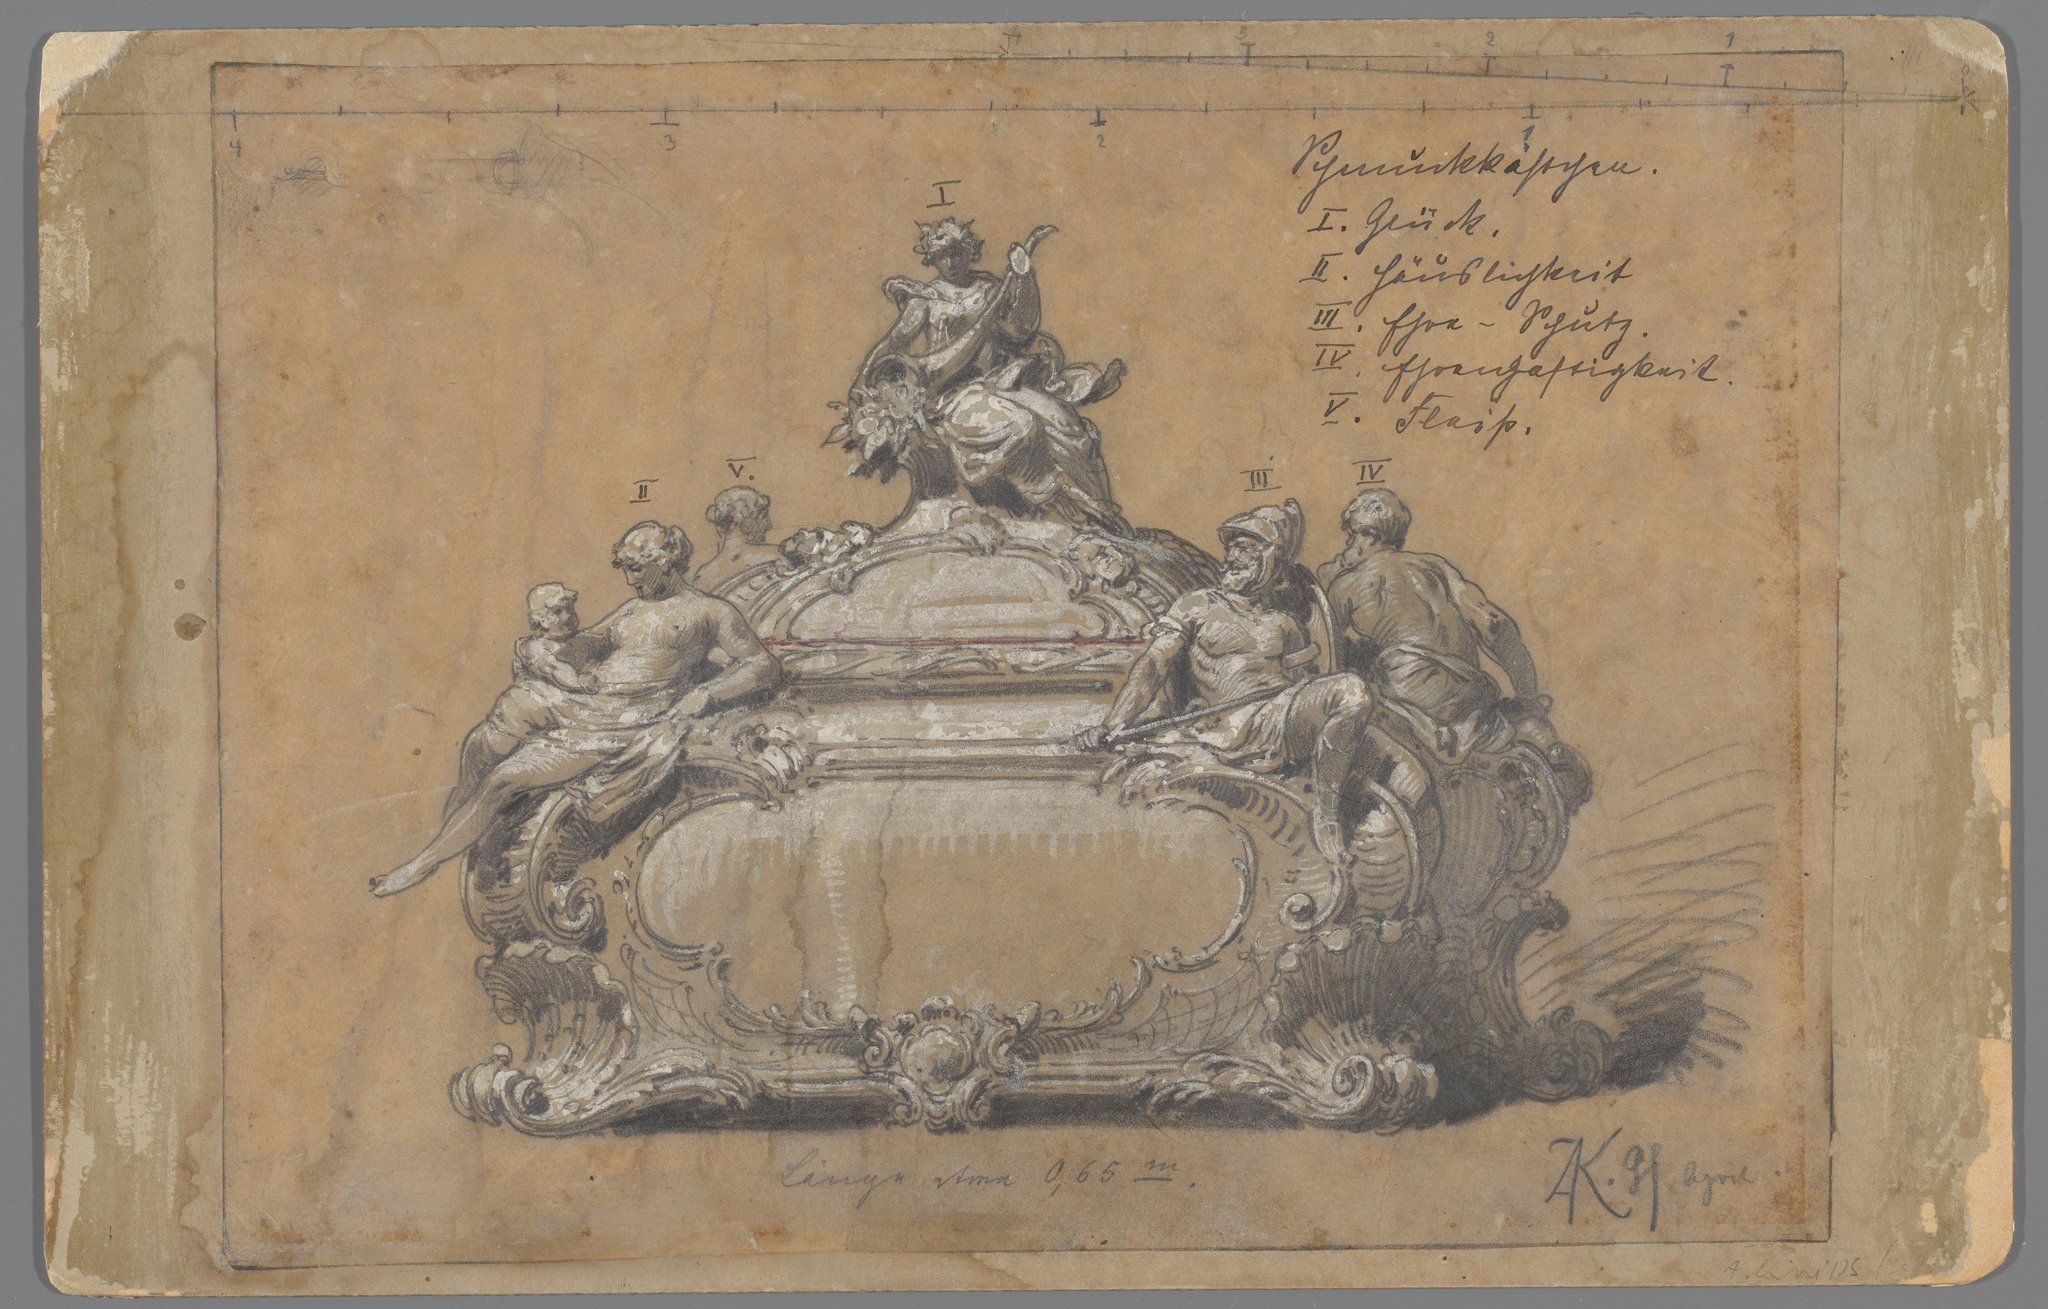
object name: design drawing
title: Ontwerp voor een juwelenkist van porselein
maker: alexander kips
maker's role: draughtsman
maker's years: 1858-1910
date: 1891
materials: chalk, paper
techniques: hogen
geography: berlin